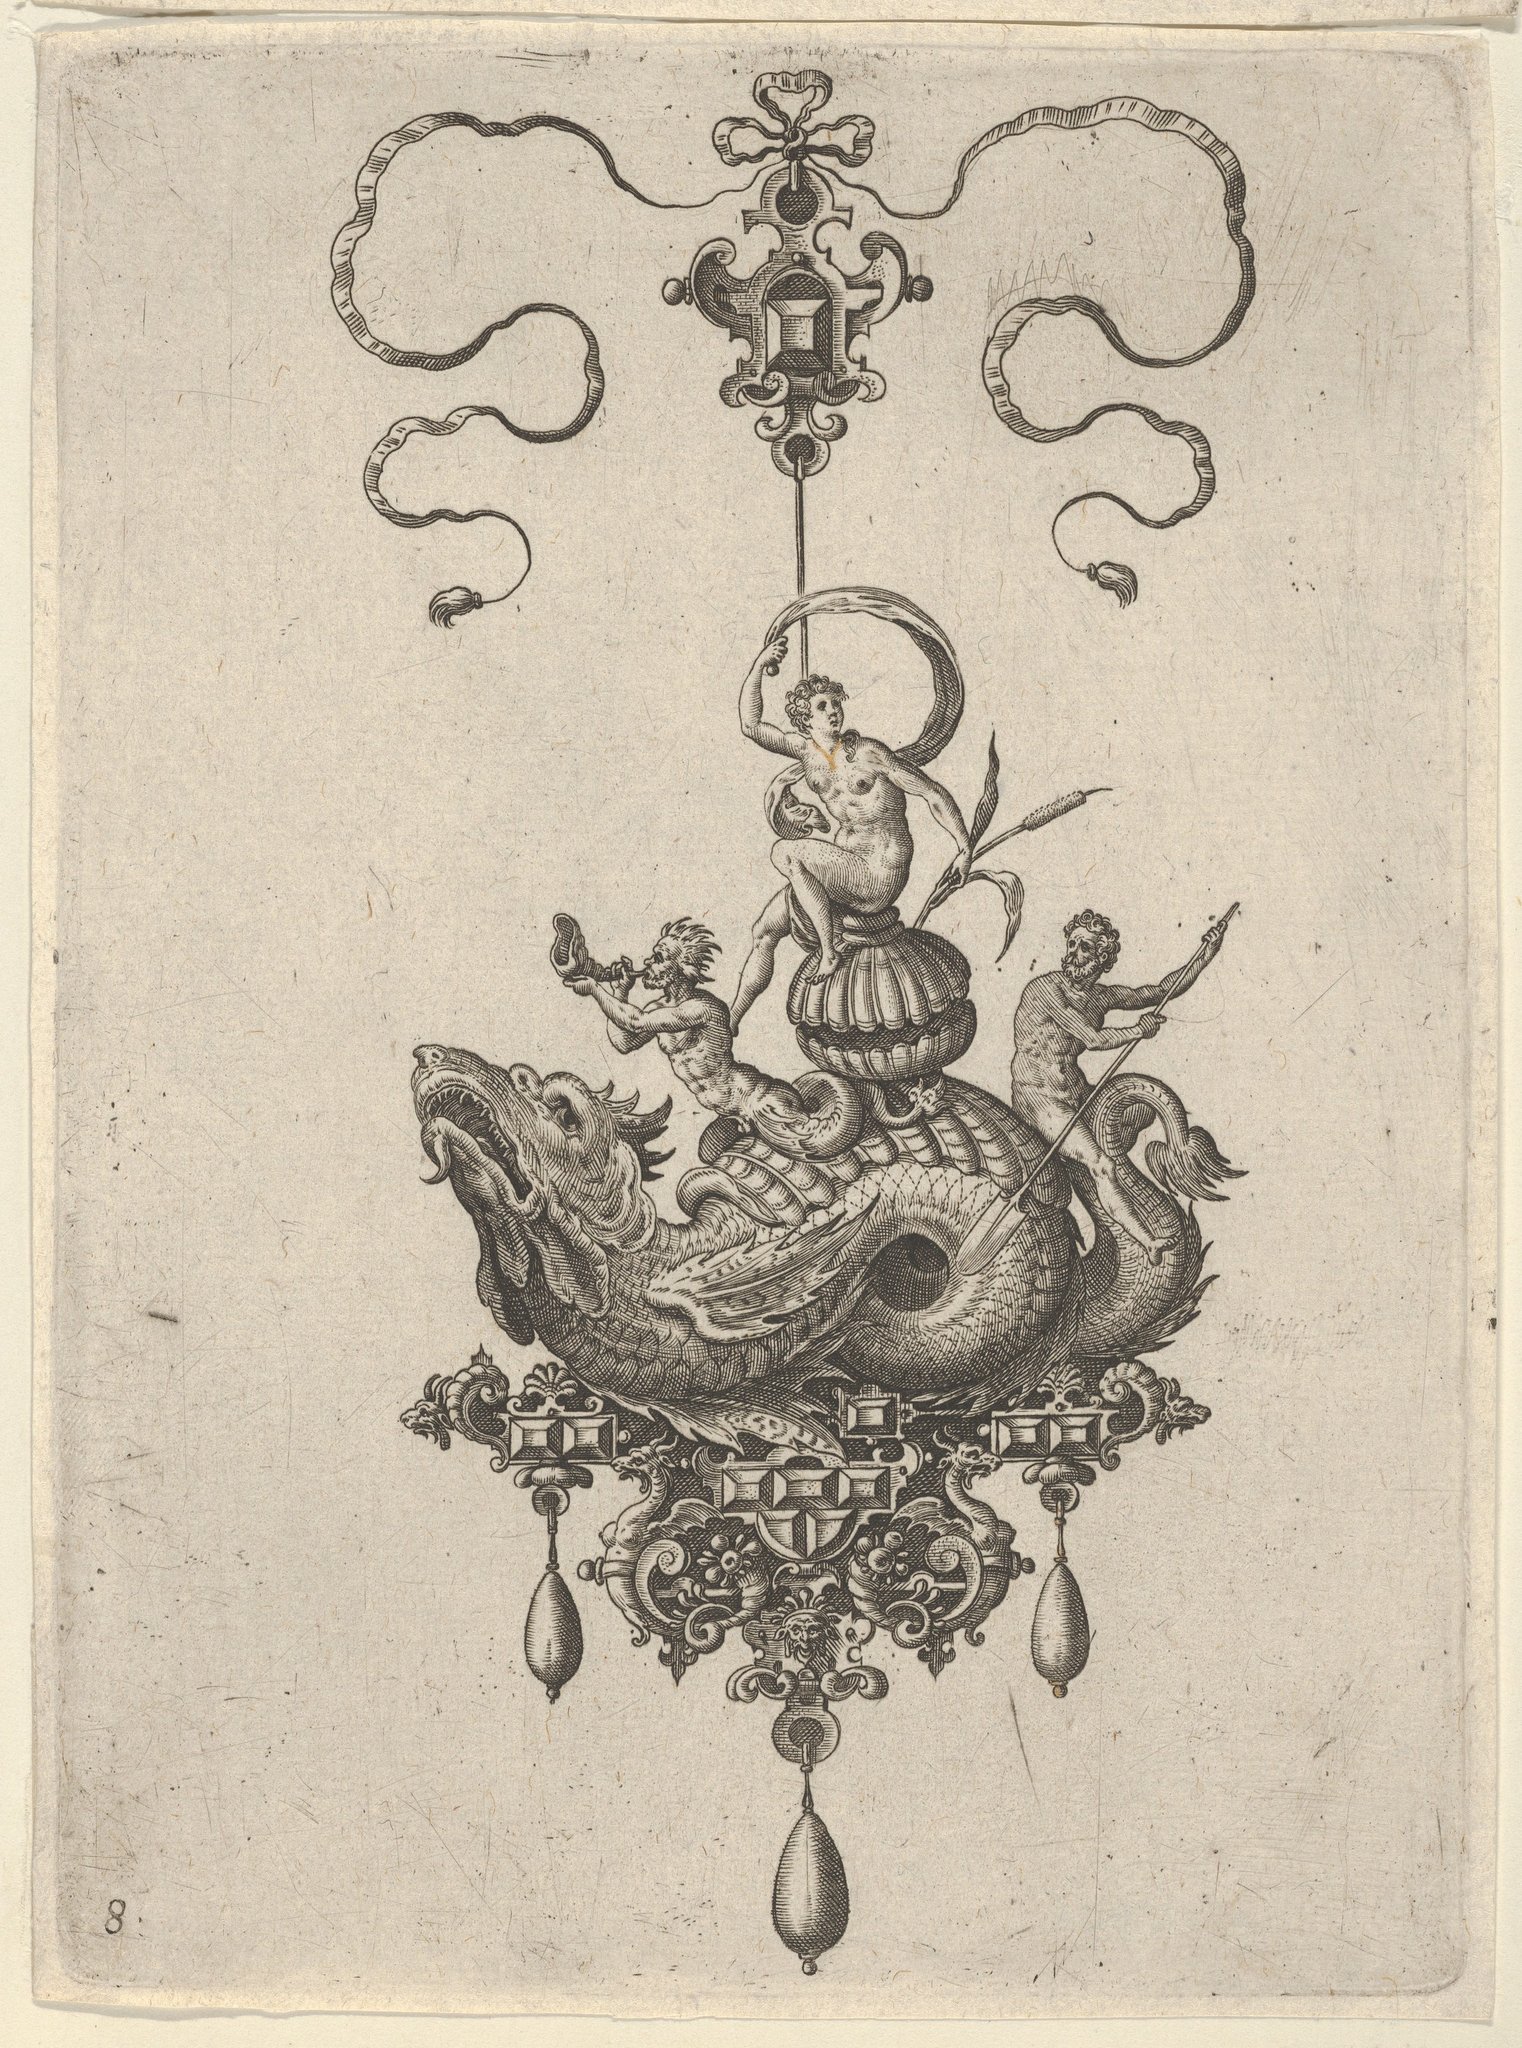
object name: print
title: Pendant Design with a Sea Monster Carrying a Woman on a Shell Flanked by a Triton and a Man with an Oar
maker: adriaen collaert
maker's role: artist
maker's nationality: netherlandish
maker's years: 1560-1618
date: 1582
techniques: engraving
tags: pendants,female nudes,triton,monsters,shells